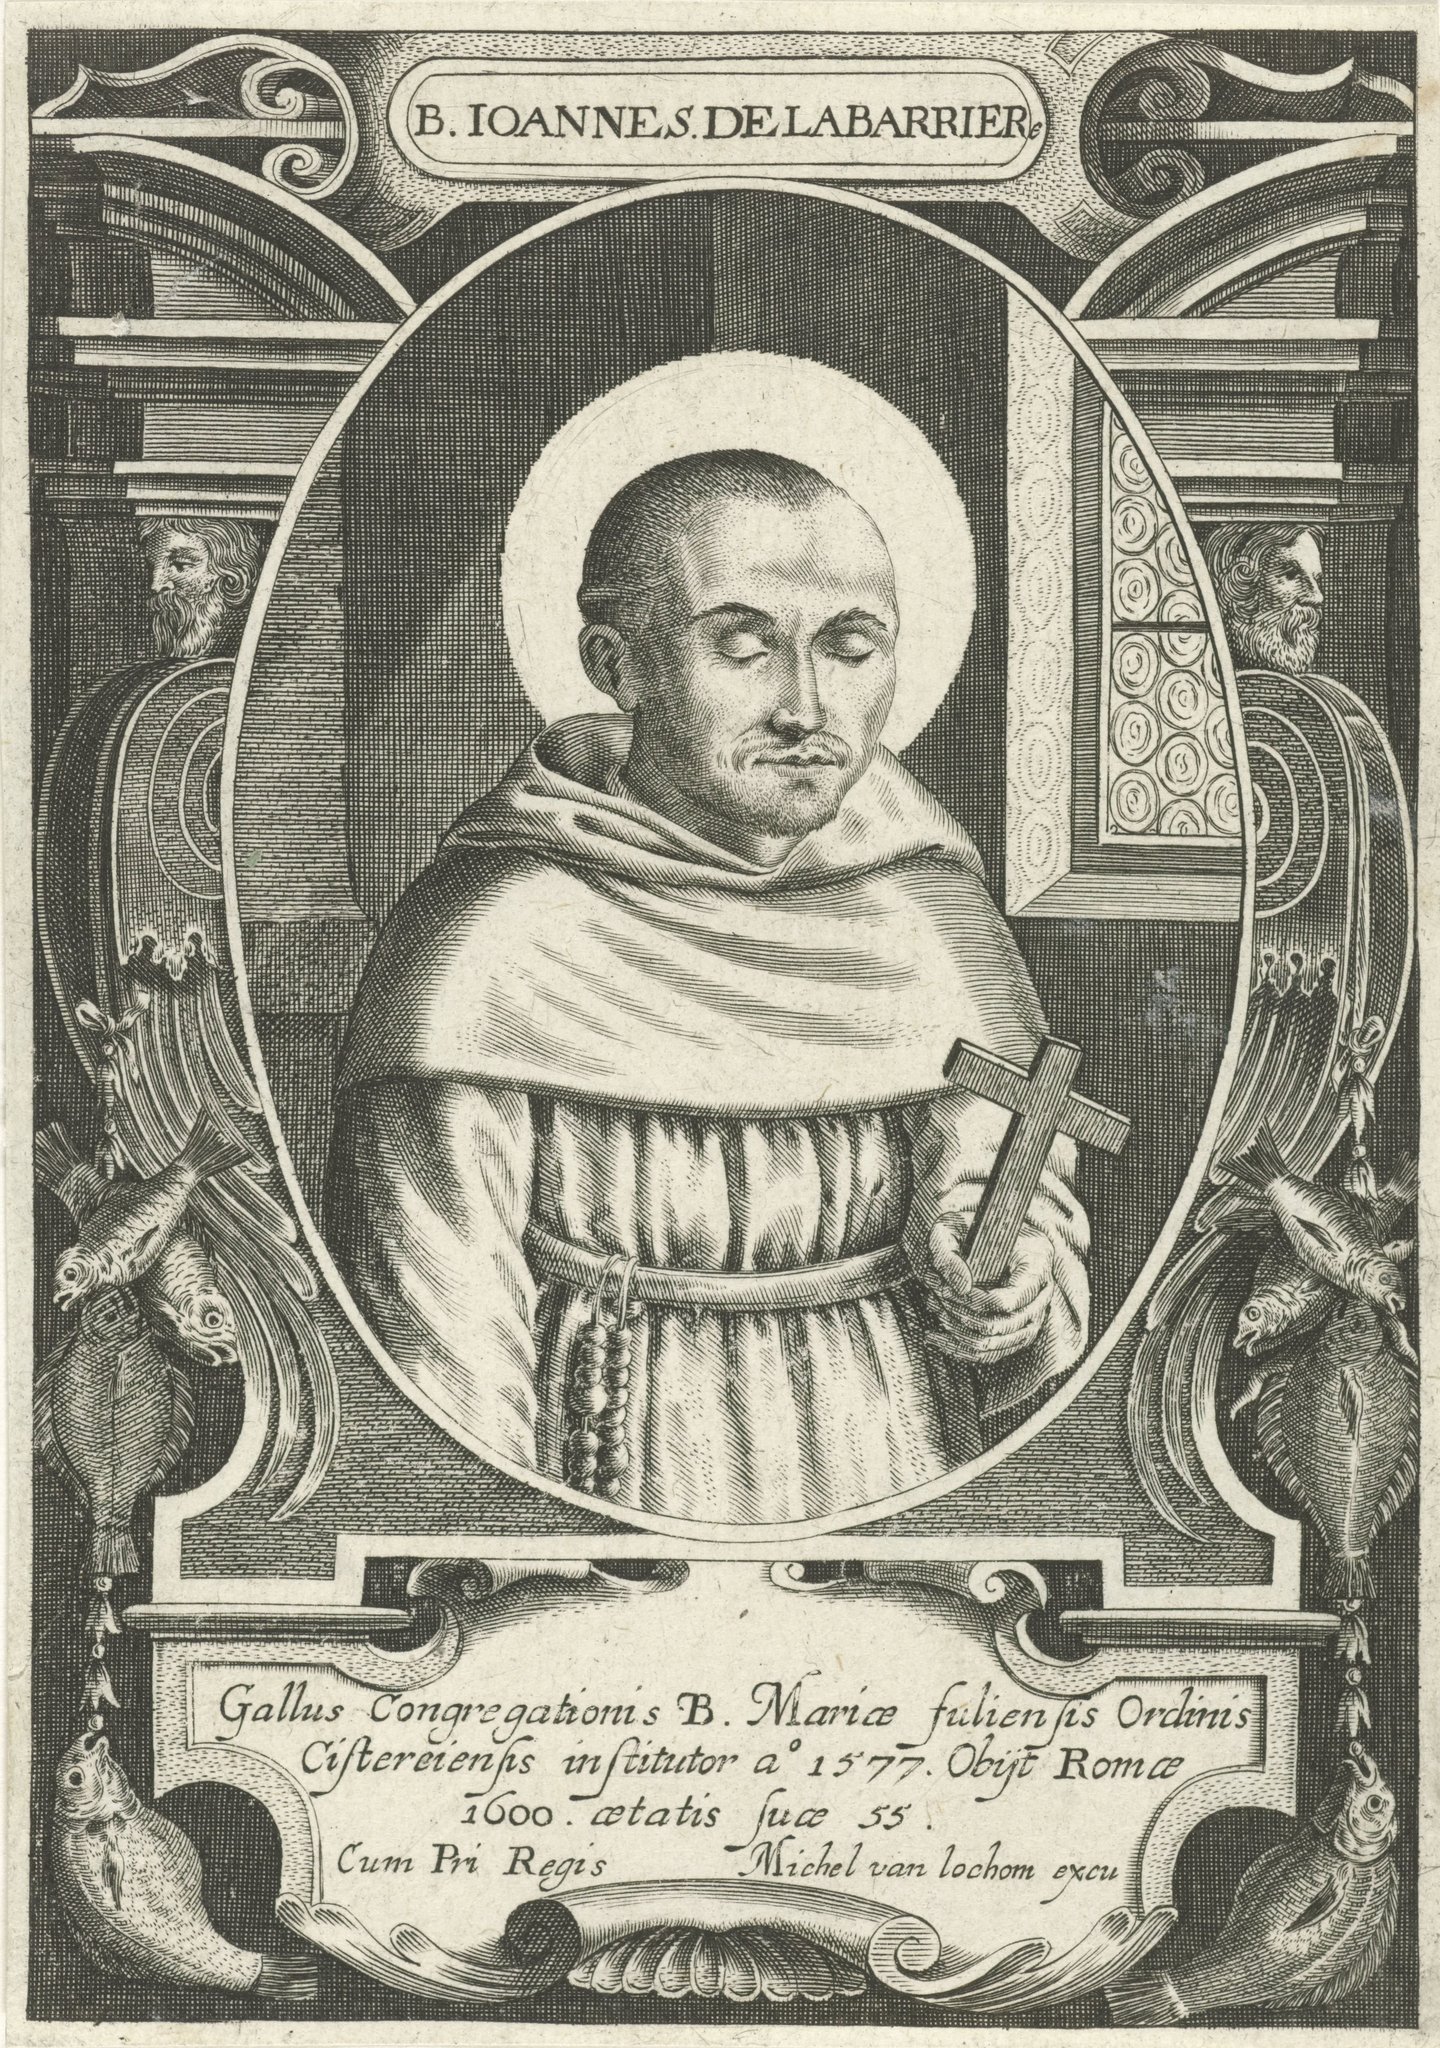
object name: print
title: Heiligen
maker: michel van lochom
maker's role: print maker, publisher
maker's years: 1601-1647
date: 1611-1647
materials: paper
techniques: engraving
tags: saints, monastic orders, monastic life: cistercians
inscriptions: collector's mark: Lugt 2166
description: Portret van de heilige Johannes de la Barriere, hervormer van de Cistercienser orde.